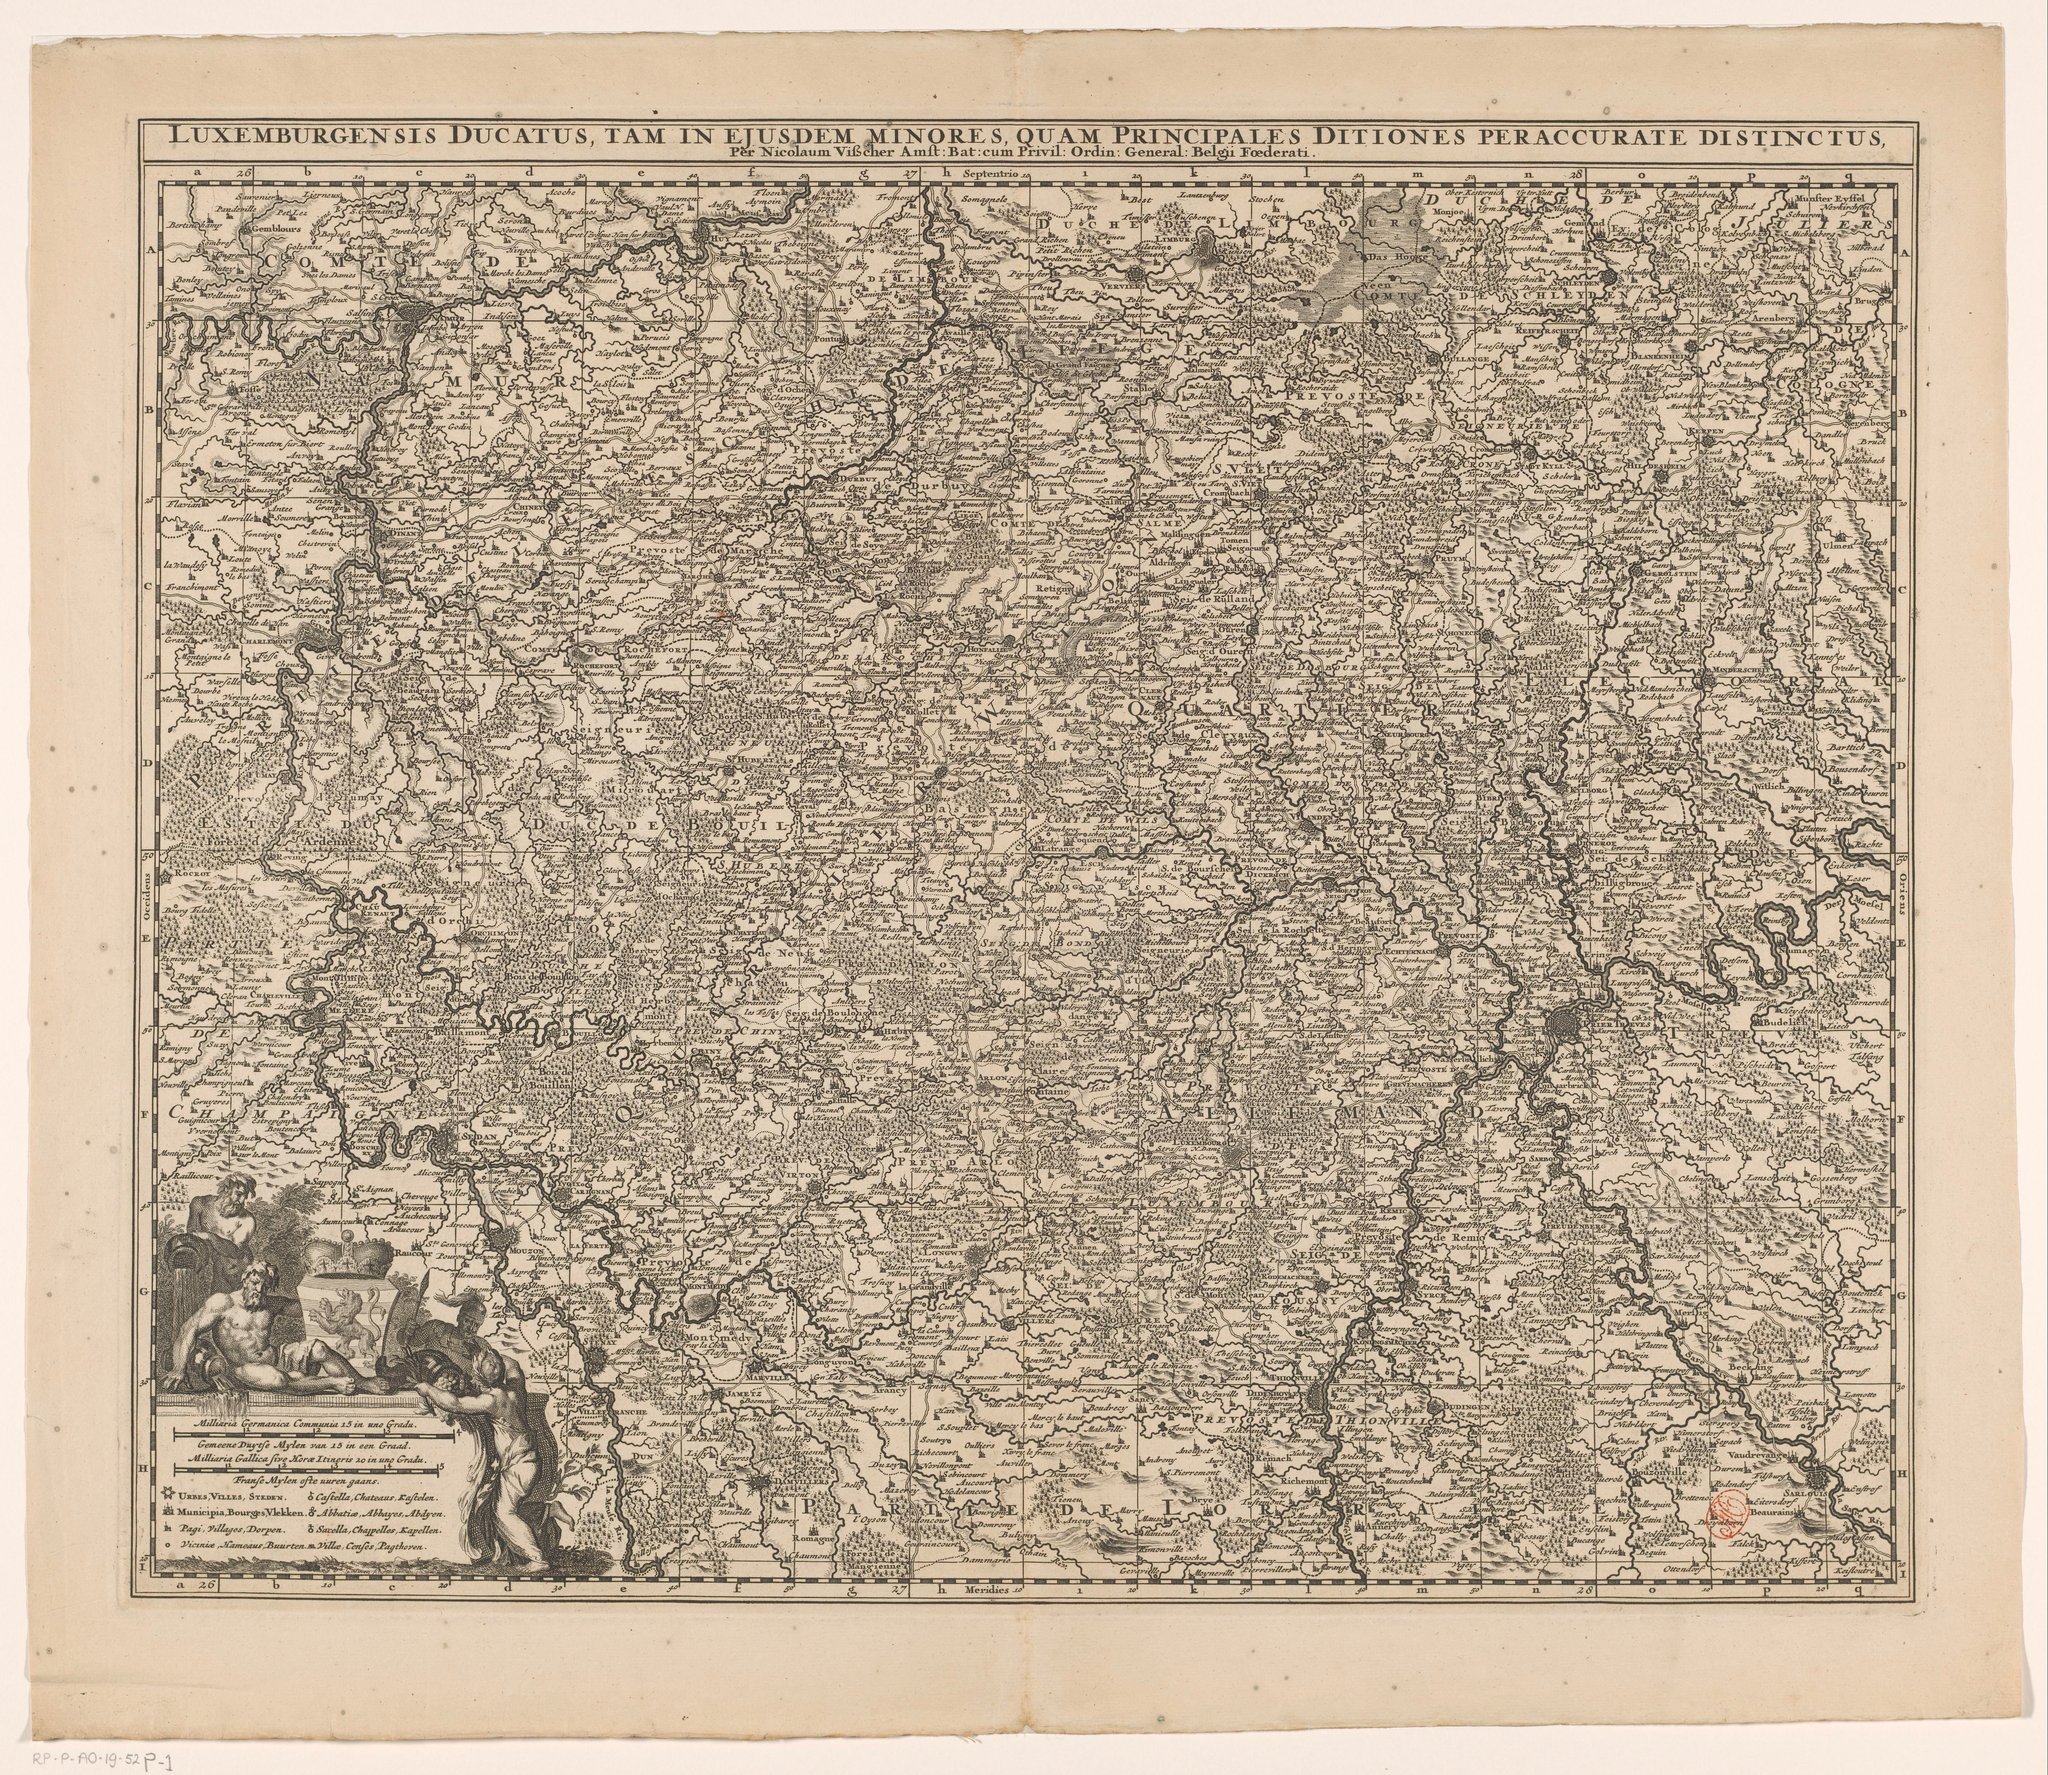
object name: print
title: Luxemburgensis ducatus, tam in ejusdem minores, quam principales (...)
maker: Anonymous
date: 1677-1720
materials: paper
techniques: engraving, etching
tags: maps of separate countries or regions, river personified, 'fiumi' (ripa) - hh - ideal landscapes, coat of arms (as symbol of the state, etc.) (+ province; provincial)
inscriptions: collector's mark: Lugt 195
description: Kaart van het hertogdom Luxemburg. De titel in een balk boven de kaart. Linksonder een cartouche met legenda en twee schaalstokken: 4 Gemeene Duytse Mylen van 15 in een Graad / 5 Franse Mylen ofte uuren gaans. Boven de cartouche het wapen van het hertogdom Luxemburg. De kaart is voorzien van een zoekrooster en een gradenverdeling langs de randen.